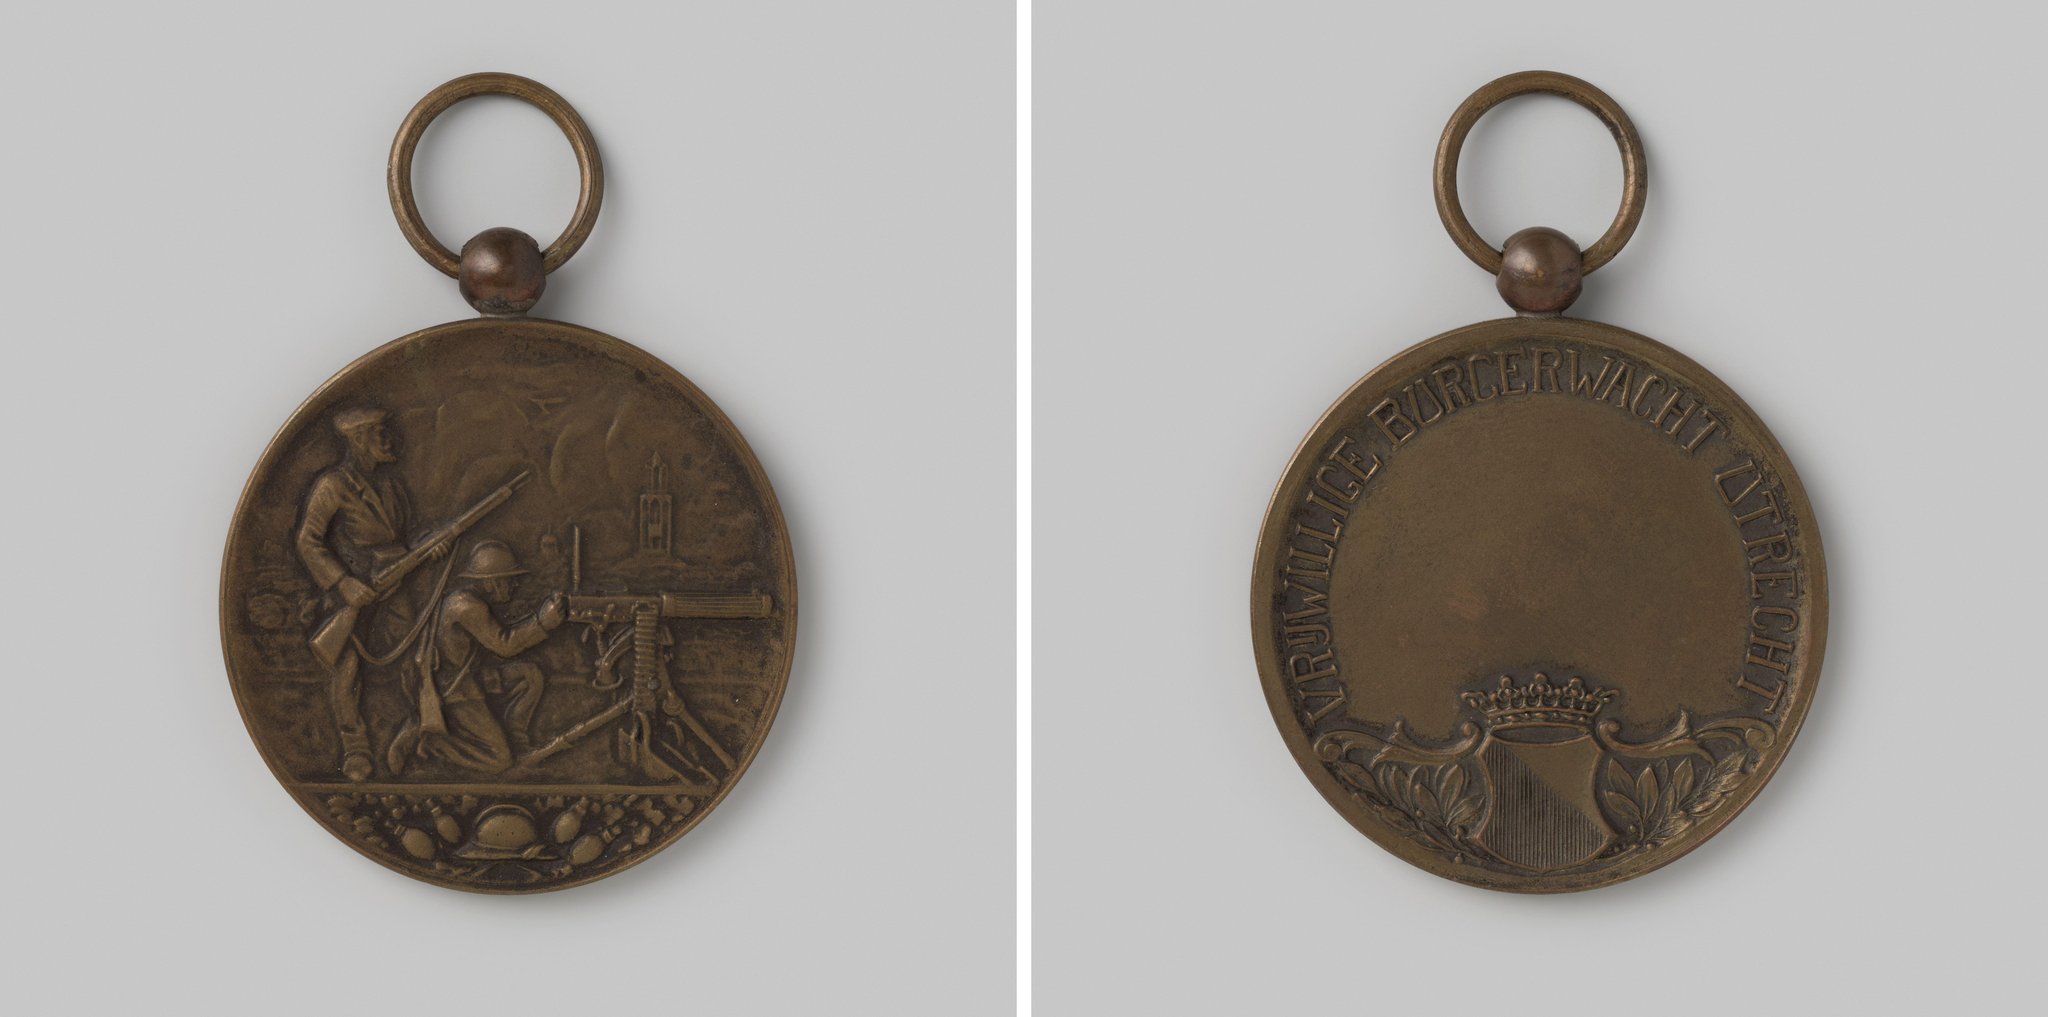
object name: history medal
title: Beloningspenning van de Vrijwillige Burgerwacht Utrecht (1918)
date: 1918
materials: bronze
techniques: striking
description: Bronzen penning met bal en draagoog, op de voorzijde militairen te veld, in afsnede militaire attributen, op de keerzijde een inscriptieruimte met omschrift boven een gekroond Utrechtsstadswapenschild tussen lauwertakken.